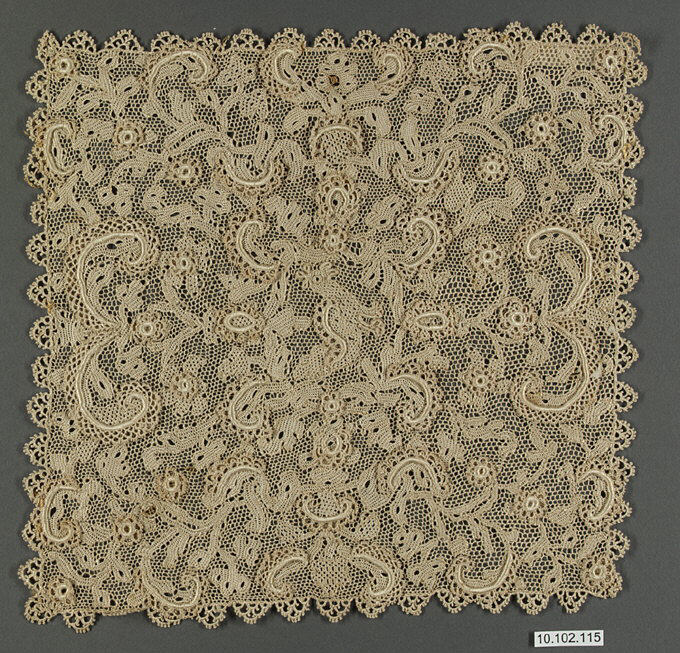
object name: square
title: Square (one of four)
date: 1701-1800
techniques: lace